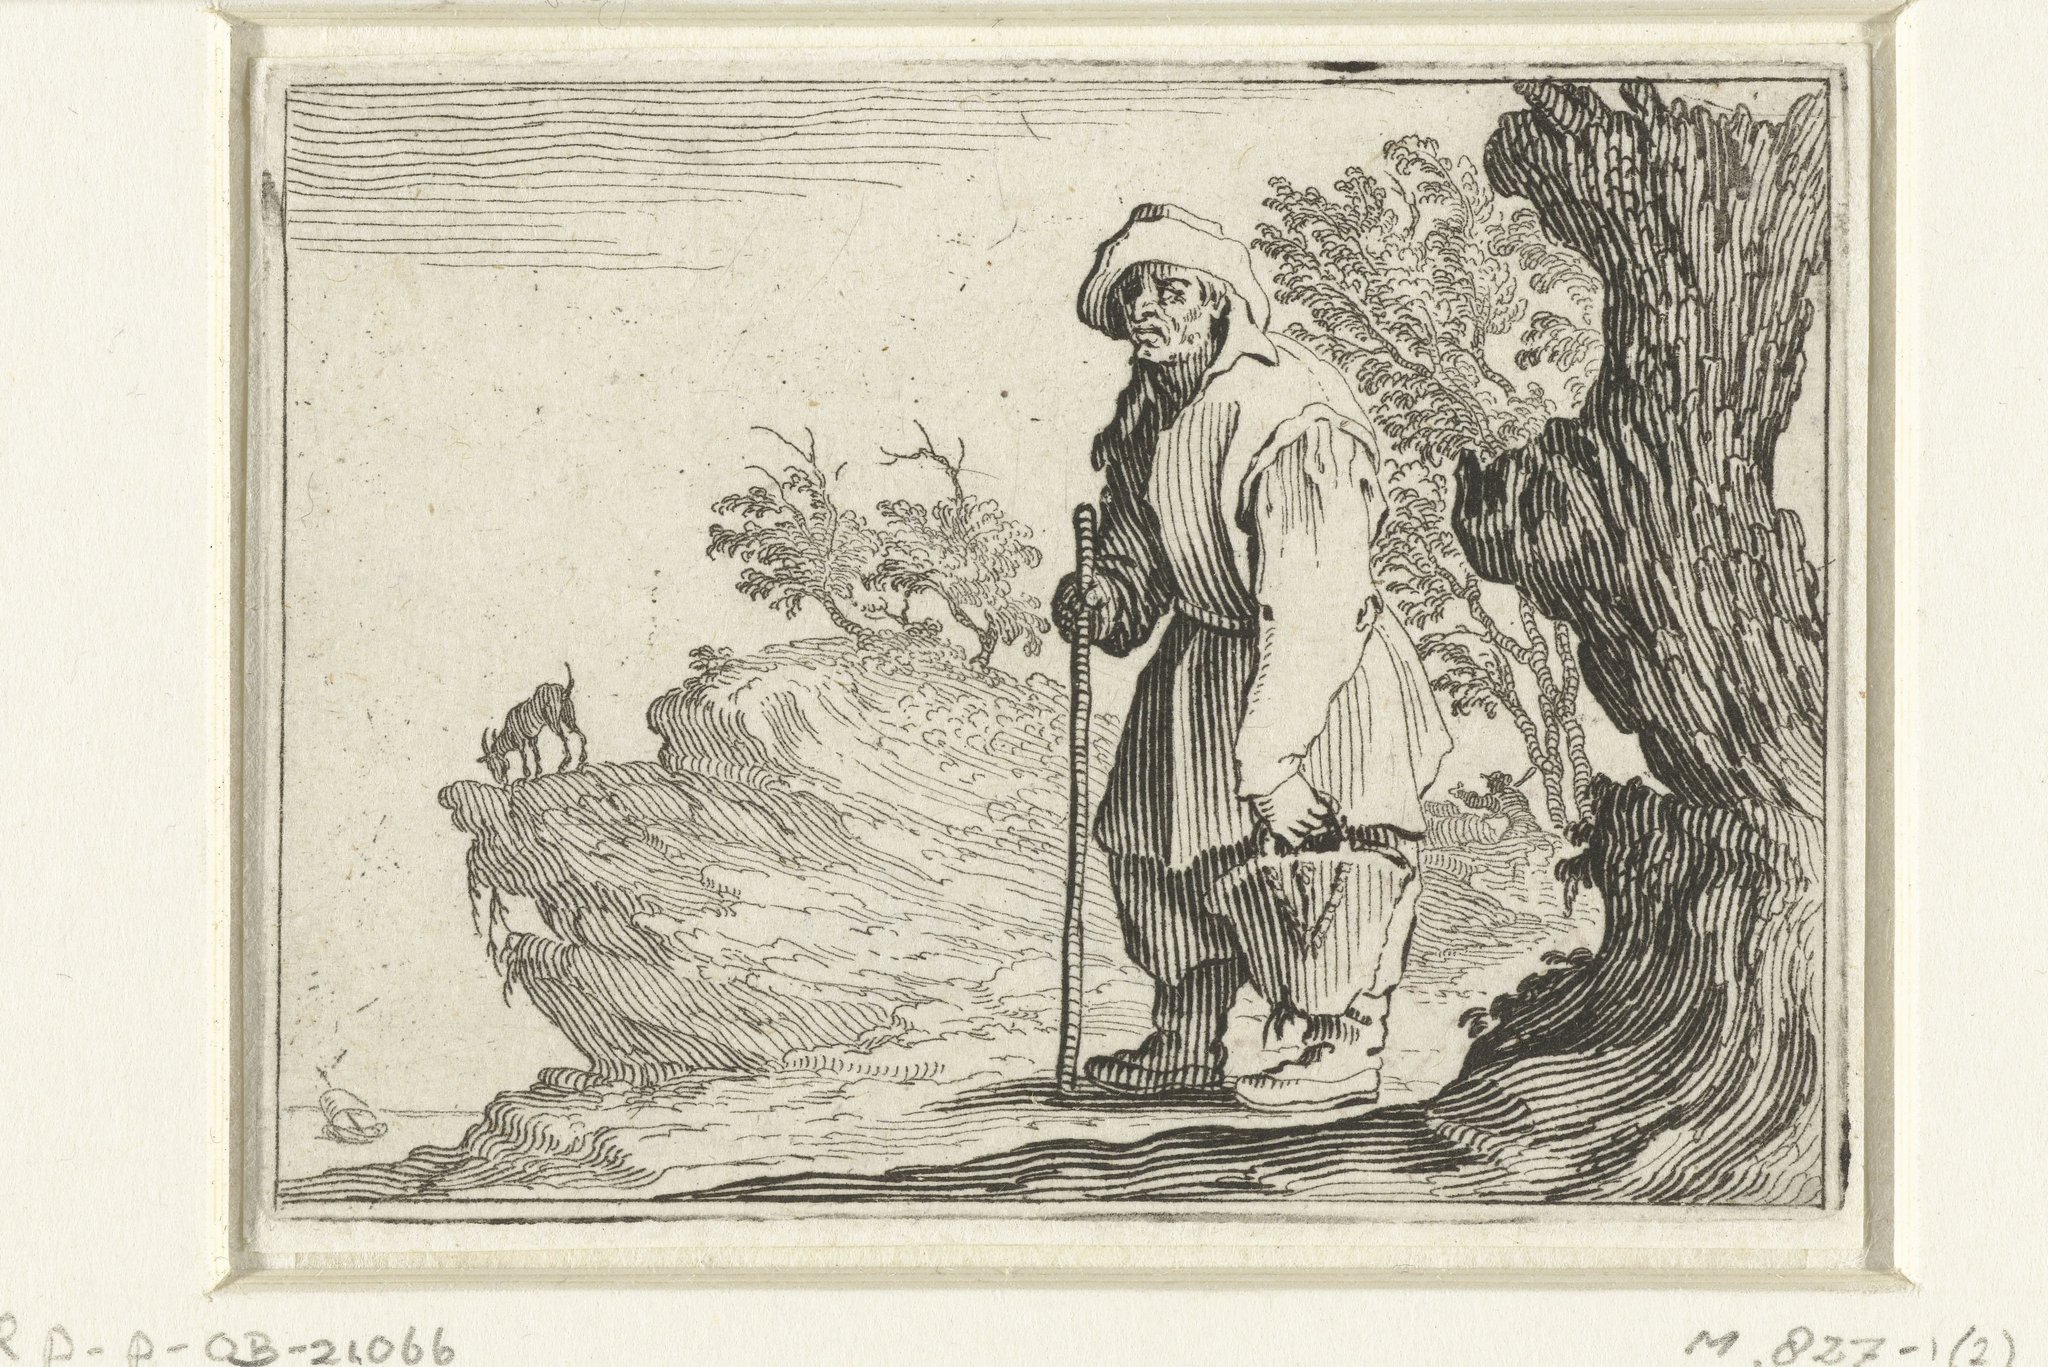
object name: print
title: Man met tas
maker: jacques callot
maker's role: draughtsman, print maker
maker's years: 1592-1635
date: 1621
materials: paper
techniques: etching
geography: nancy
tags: bag (+ men's clothes), goat, coast, walking-stick, staff, cane (+ men's clothes), rocks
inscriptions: collector's mark: Lugt 240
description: Rechts op de voorgrond staat een man met een tas in de hand bij een boom, leunend op een stok. Op de achtergrond een geit op een rots en een bootje op het water. Deze prent is onderdeel van een serie van 48 prenten (50 incl. titelblad en dedicatieblad) met diverse onderwerpen (o.a. mannen en vrouwen in verschillende houdingen, landschappen, gebouwen en festiviteiten in Florence). Mogelijk zijn deze prenten bedoeld geweest als tekenvoorbeelden.